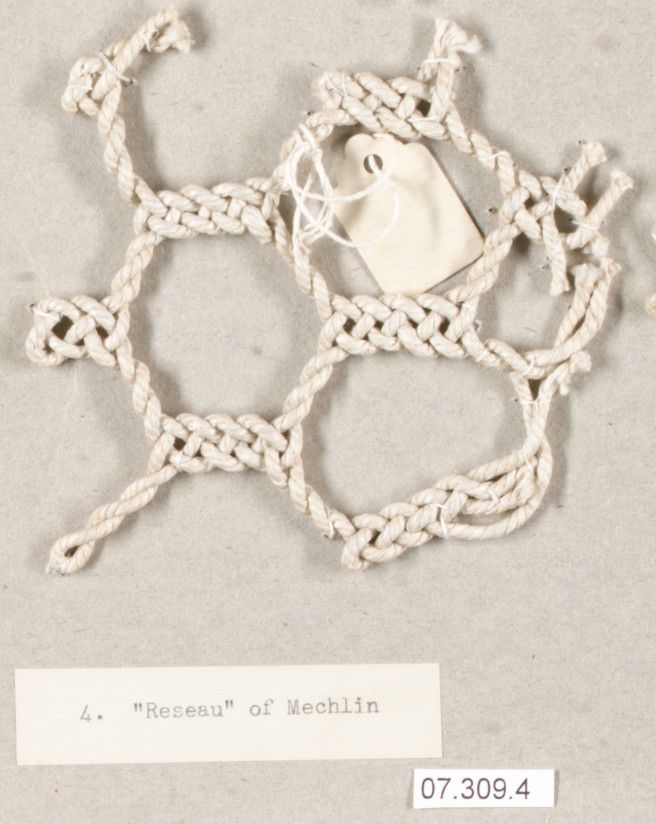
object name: stitch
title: Example of lace stitch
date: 1801-2000